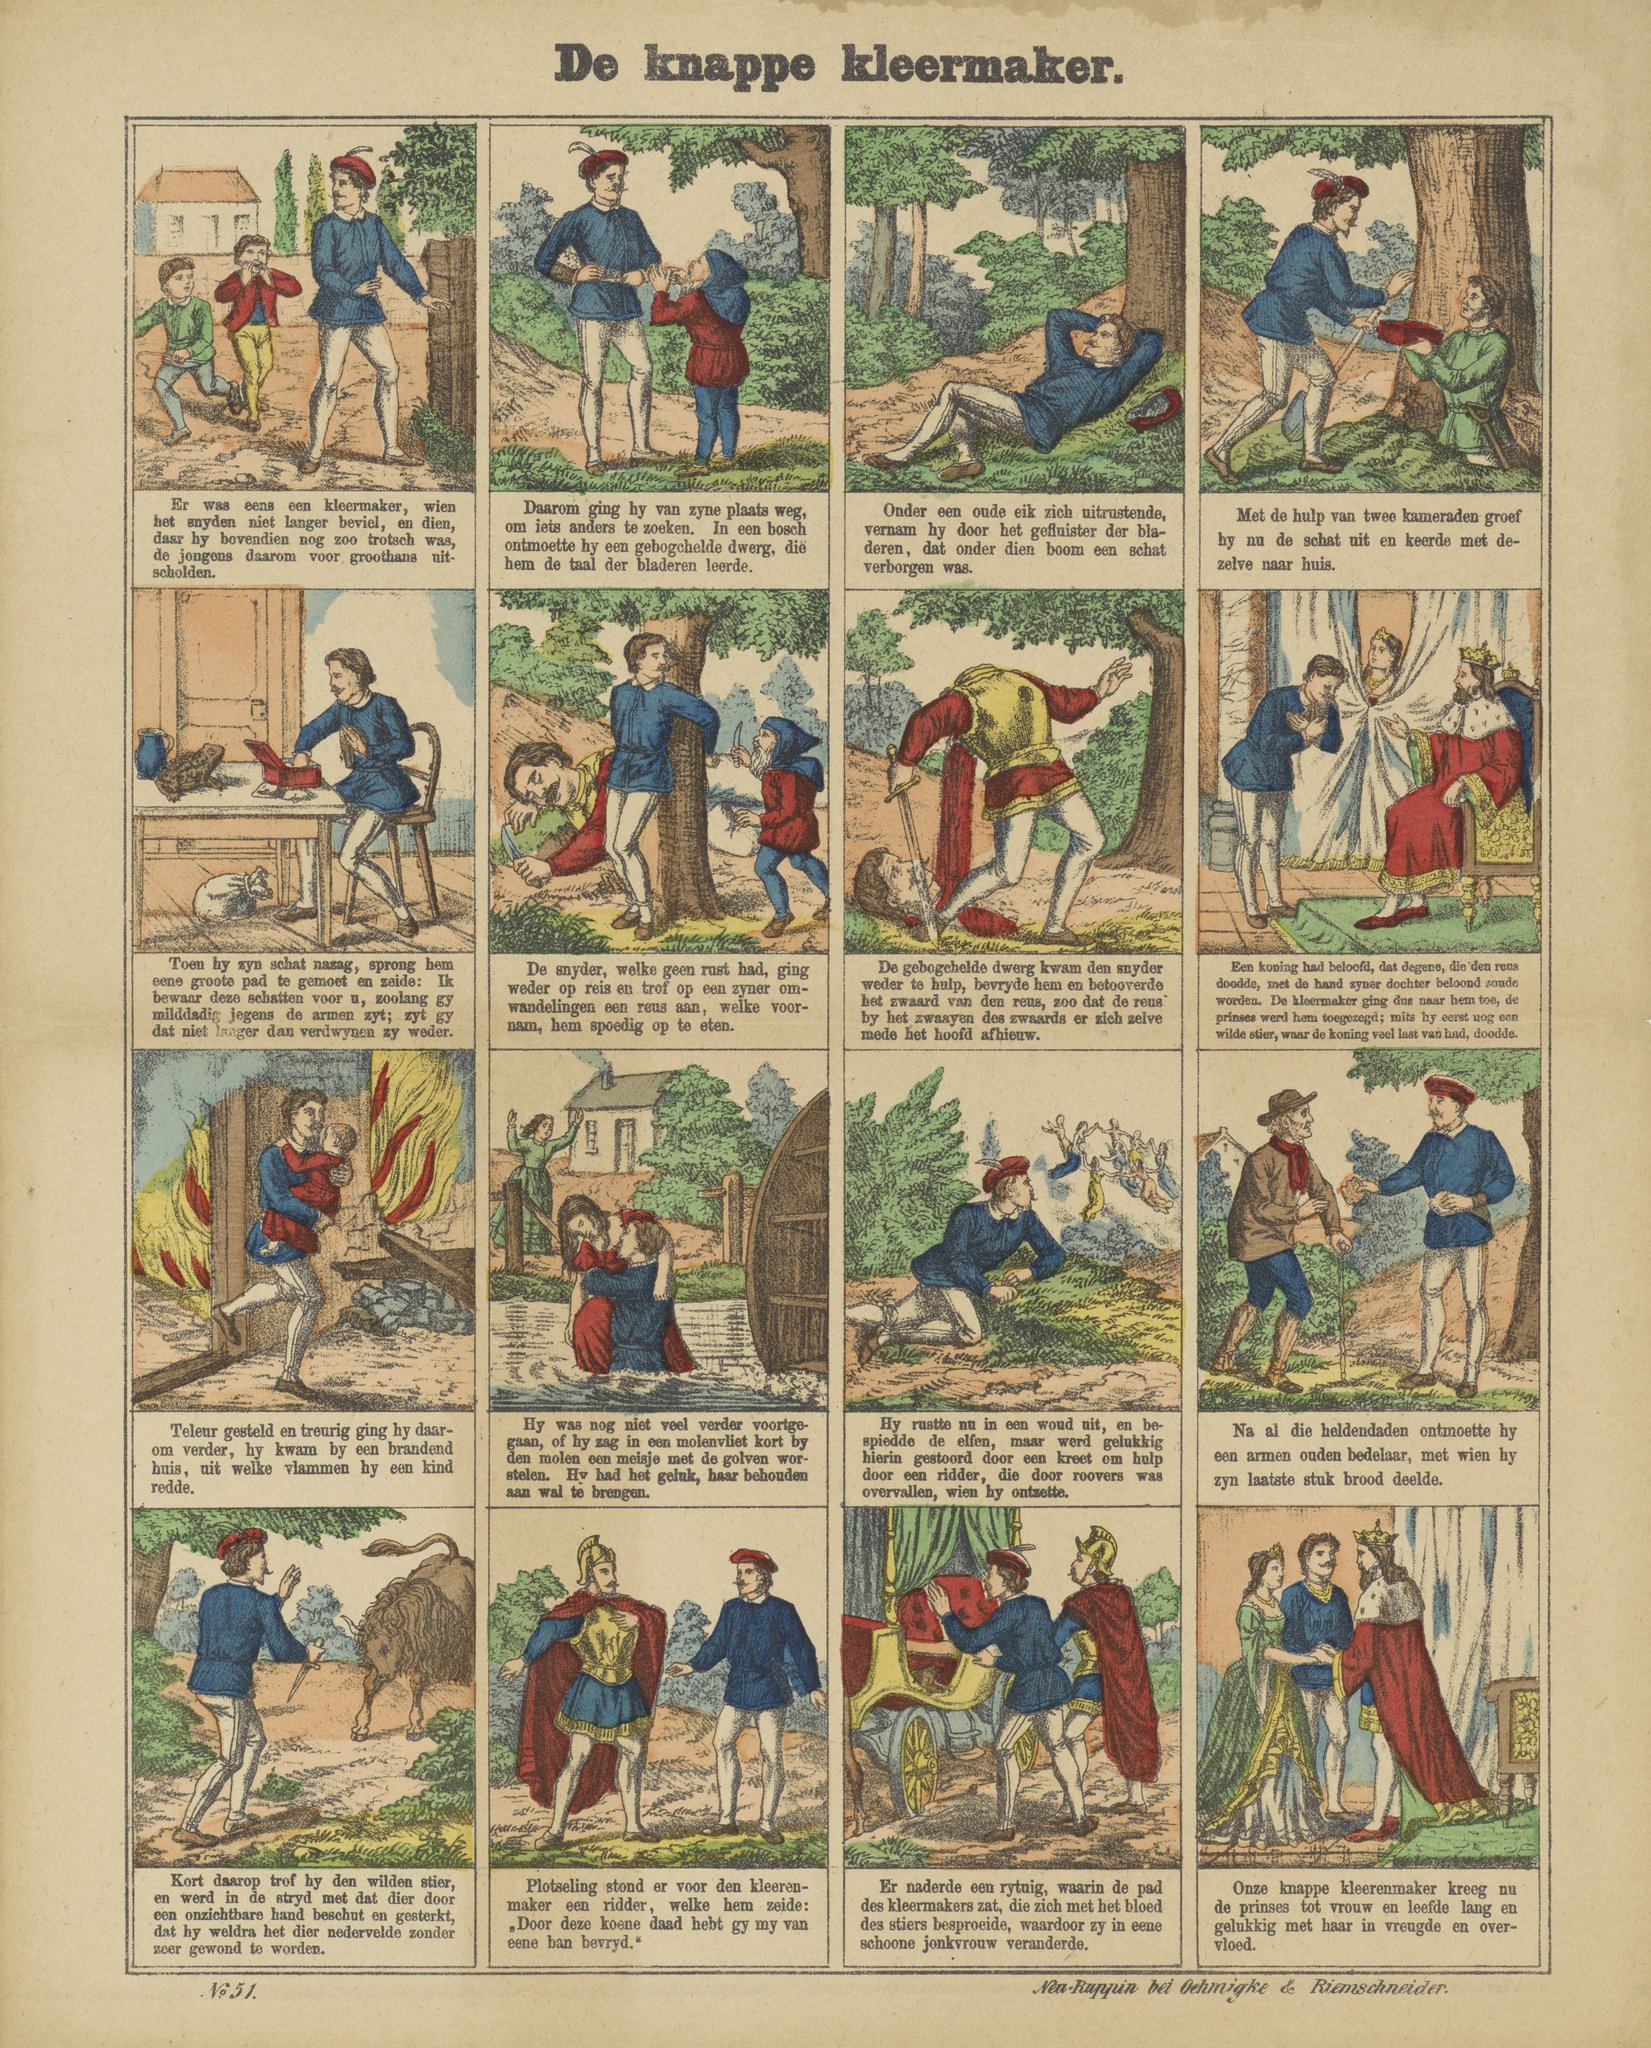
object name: popular print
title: De knappe kleermaker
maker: Anonymous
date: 1828-1937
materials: paper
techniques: hand coloring, letterpress printing, lithograph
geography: neuruppin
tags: tales and fairy tales, tailor, dressmaker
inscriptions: collector's mark: Lugt 2760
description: Blad met 16 voorstellingen uit het verhaal van de knappe kleermaker, die heldendaden verricht en met een prinses trouwt. Onder elke afbeelding een onderschrift. Genummerd linksonder: No. 51.